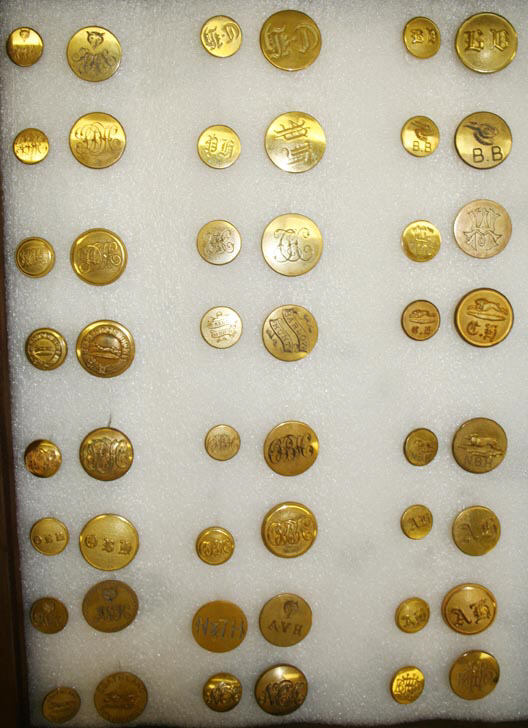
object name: button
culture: british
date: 1850-1880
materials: metal